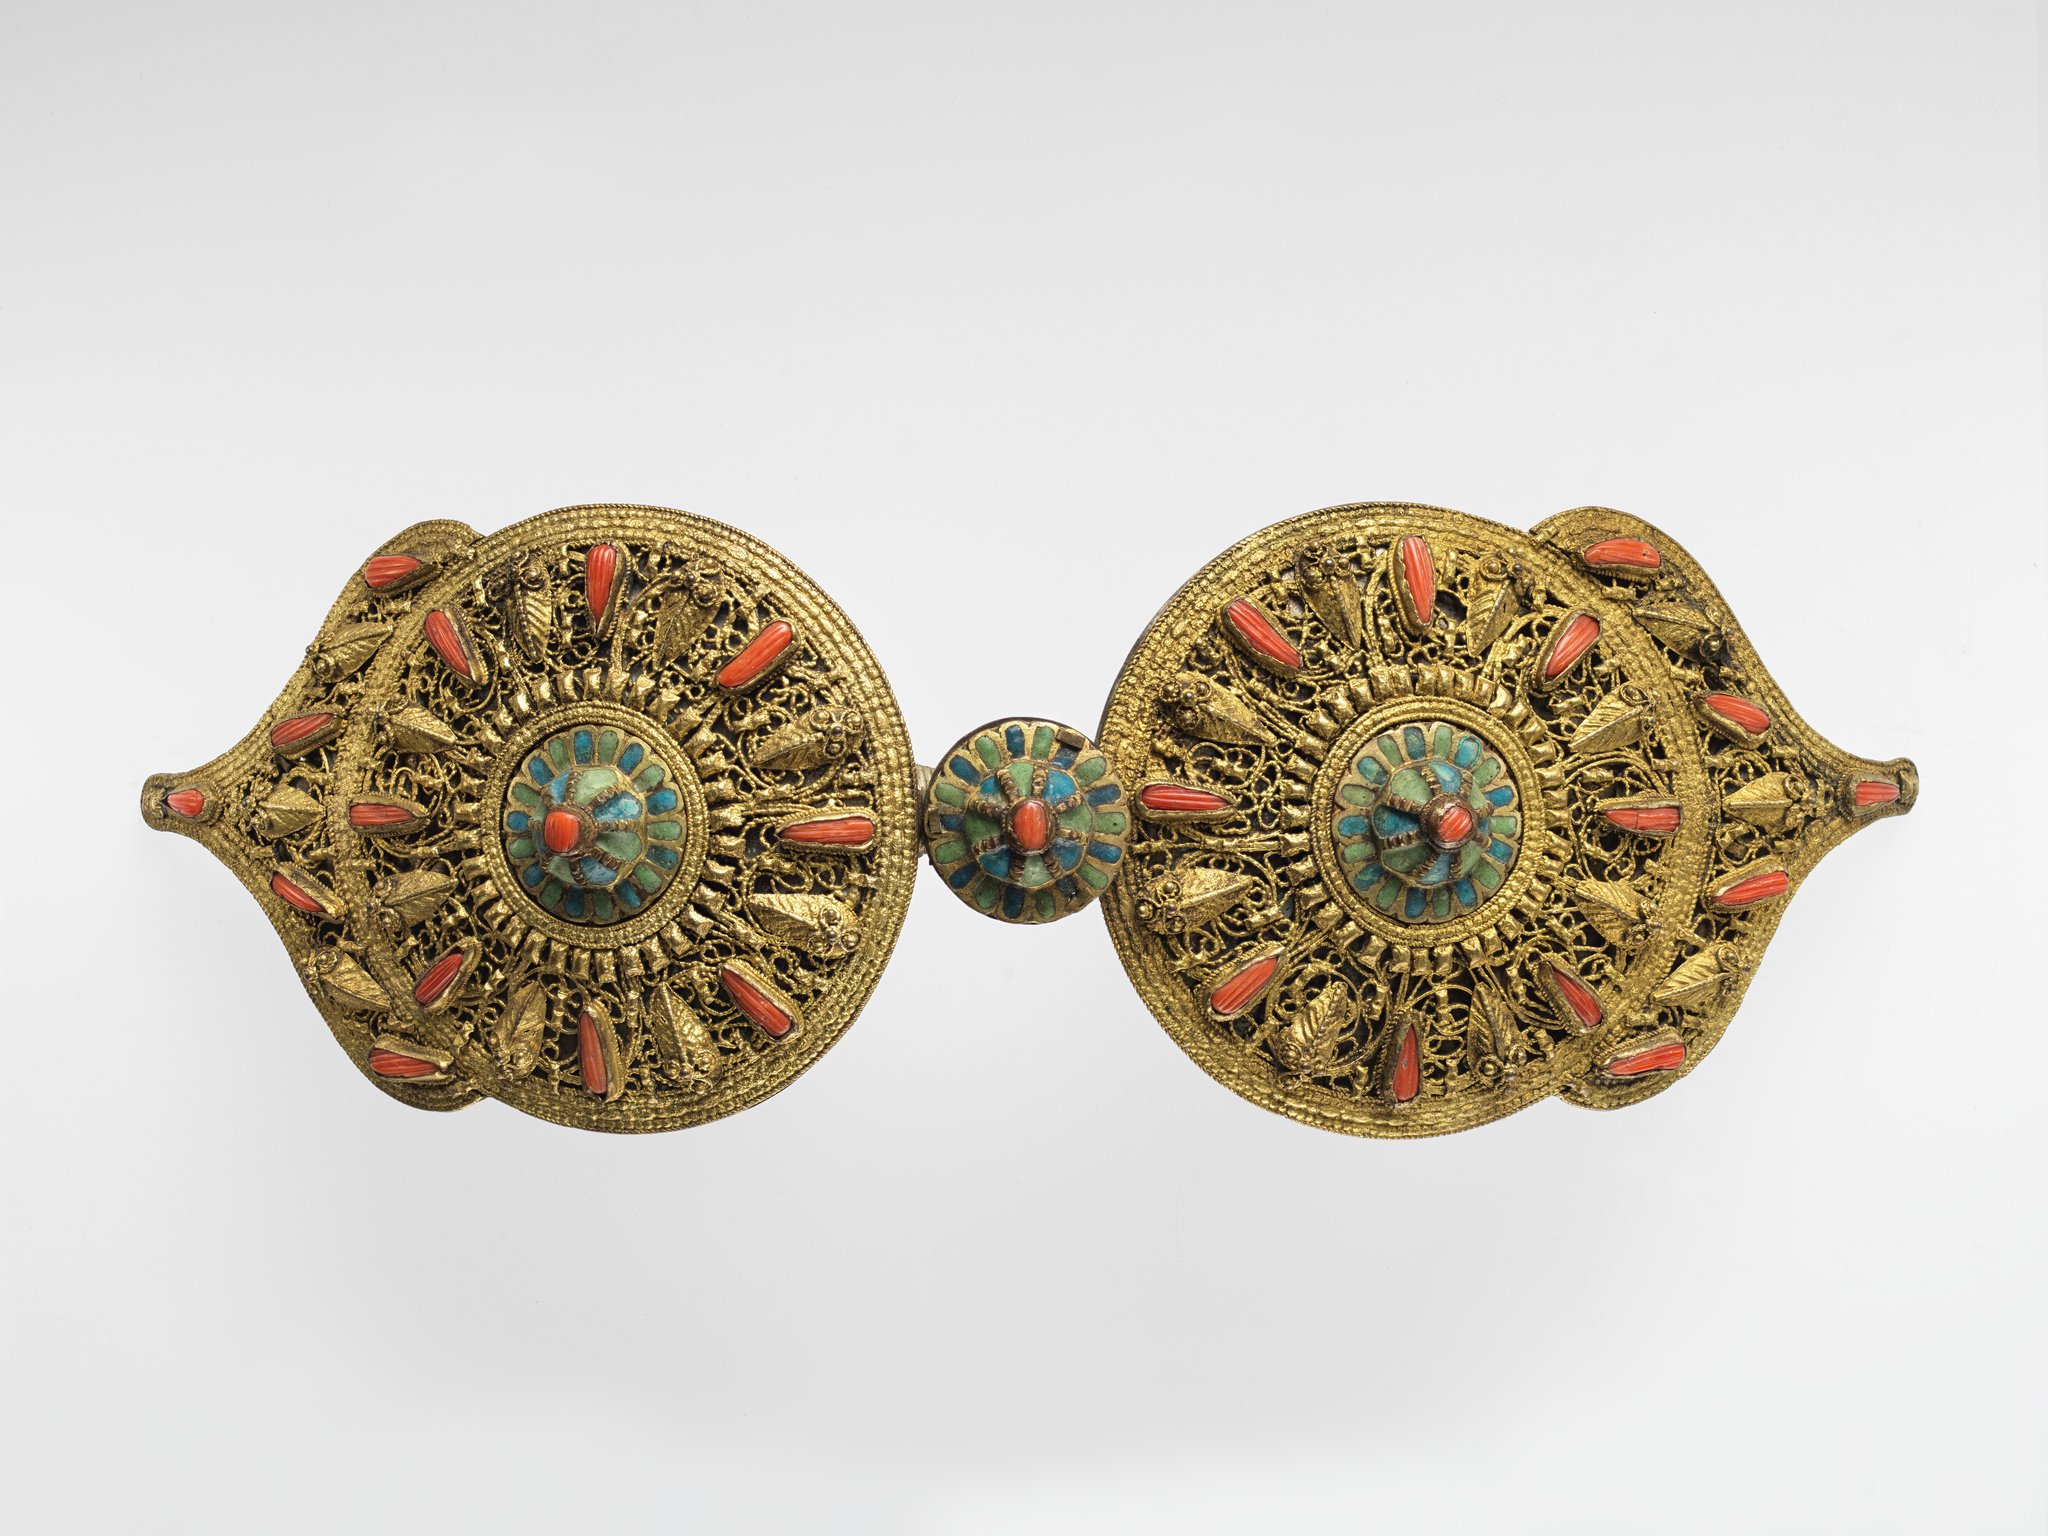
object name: girdle clasp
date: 1701-1900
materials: coral, glass, gold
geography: turkey